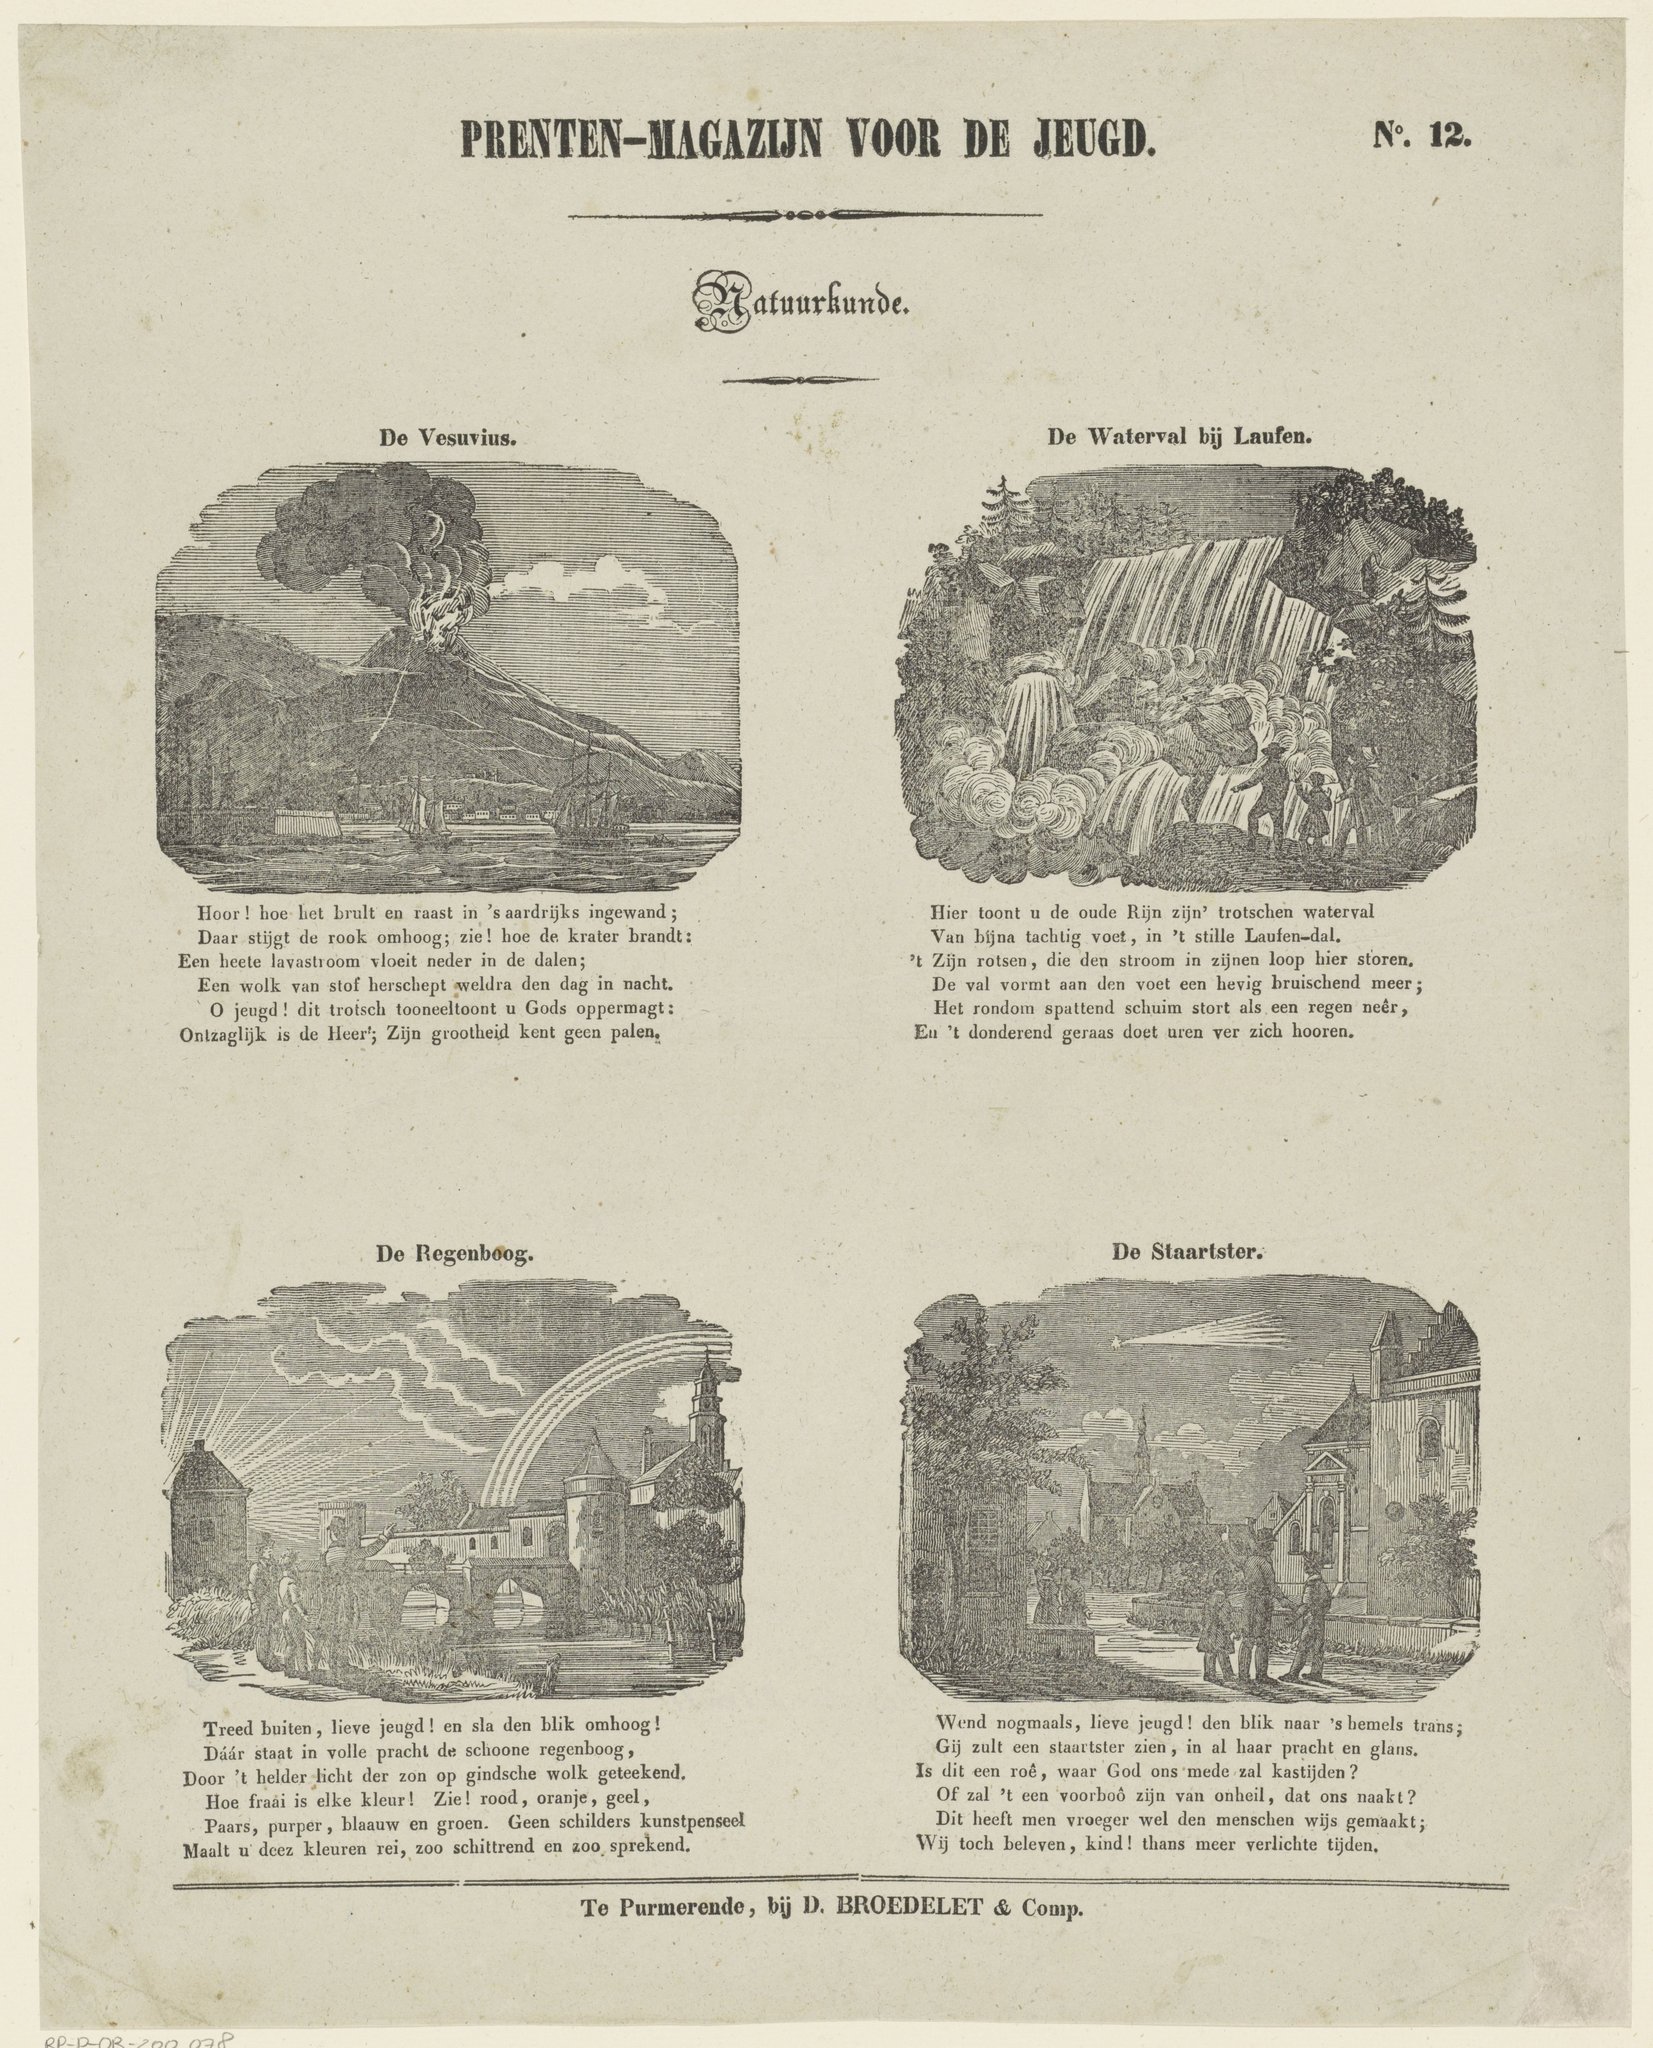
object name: print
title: Prenten-magazijn voor de jeugd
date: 1839-1841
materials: paper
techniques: letterpress printing, engraving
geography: purmerend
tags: natural phenomena, waterfall, stars, volcano, rainbow, mount vesuvius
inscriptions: collector's mark: Lugt 2760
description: Blad met 4 voorstellingen van natuurfenomenen: de Vesuvius, de Rheinfall, een regenboog en een vallende ster. Boven elke voorstelling een titel en onder elke voorstelling een zesregelig vers. Genummerd rechtsboven: No. 12.